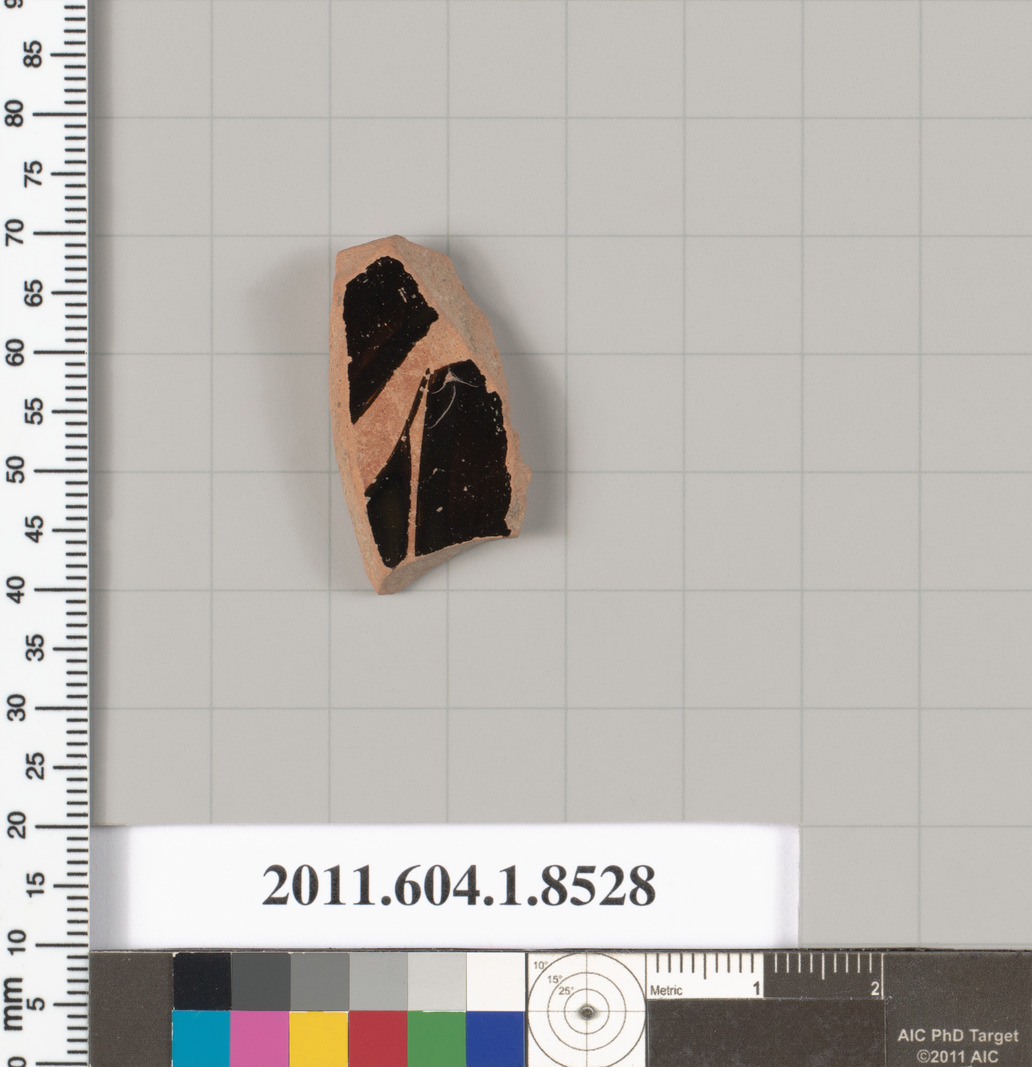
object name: kylix fragment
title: Terracotta fragment of a stemless kylix (drinking cup)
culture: greek, attic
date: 470-450 BCE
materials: terracotta